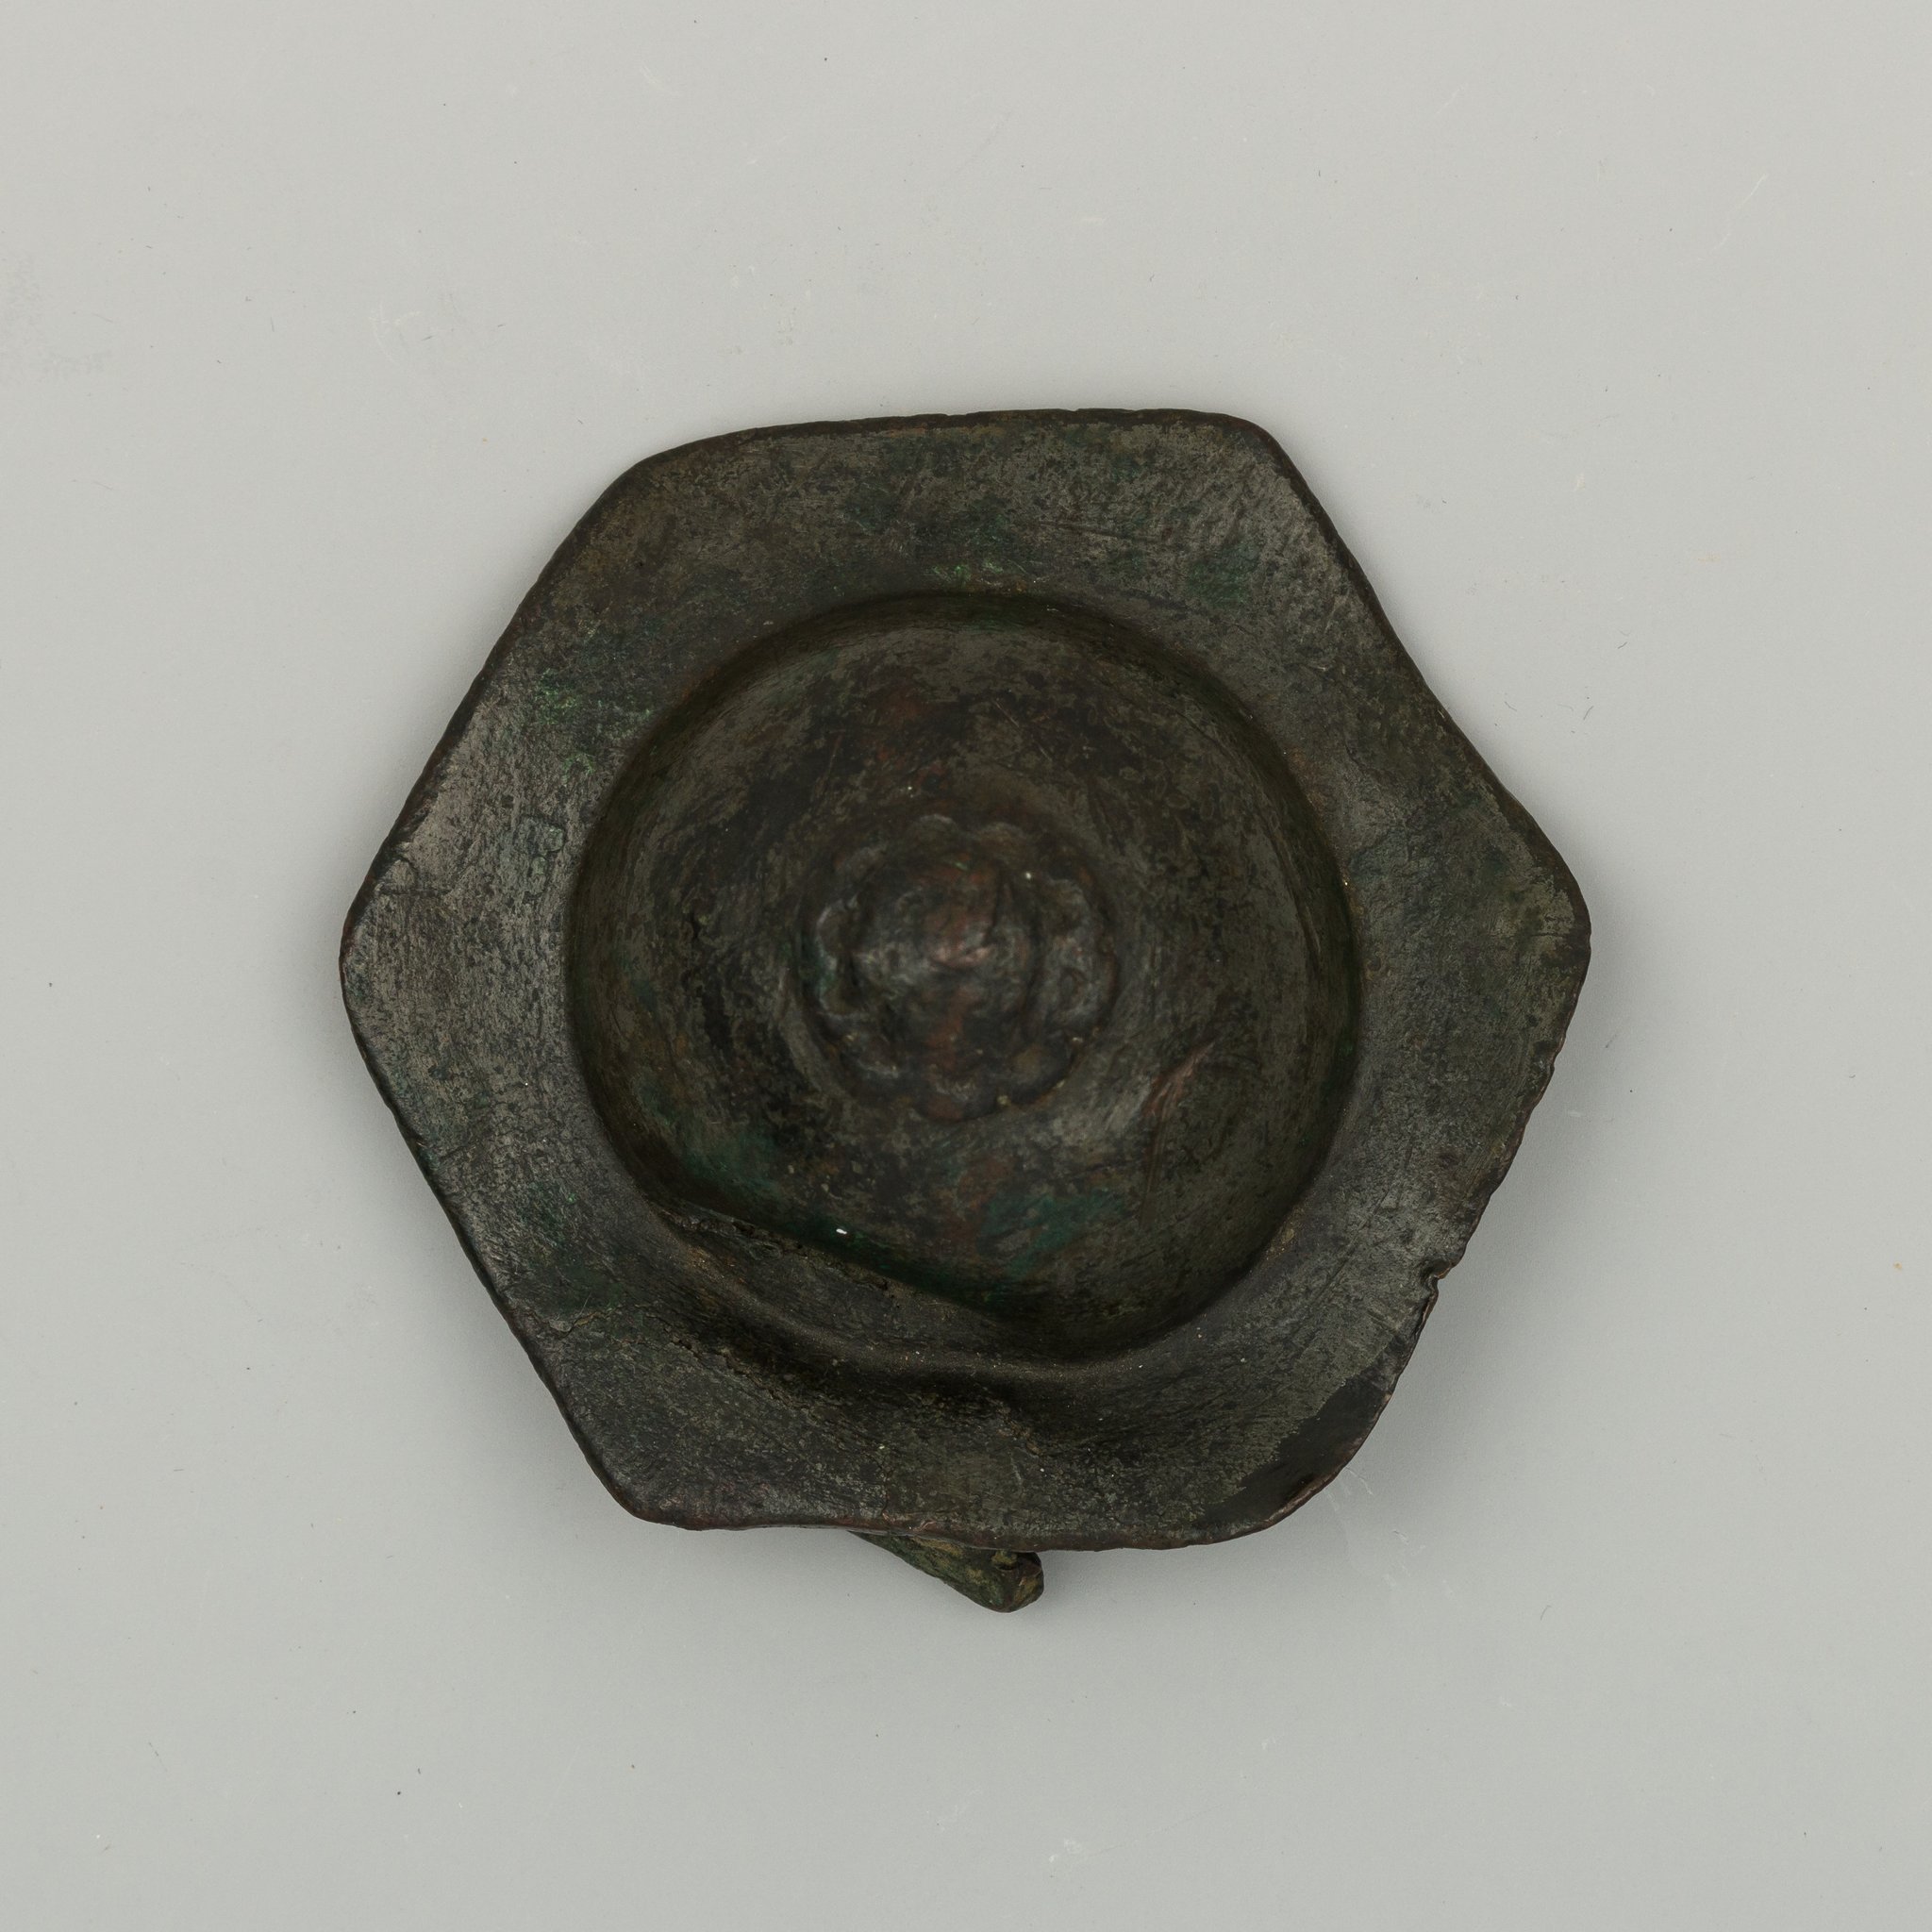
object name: harness ornament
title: Boss from a Horse Breast Collar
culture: ottoman or tatar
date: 1667-1800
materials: copper alloy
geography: ottoman empire